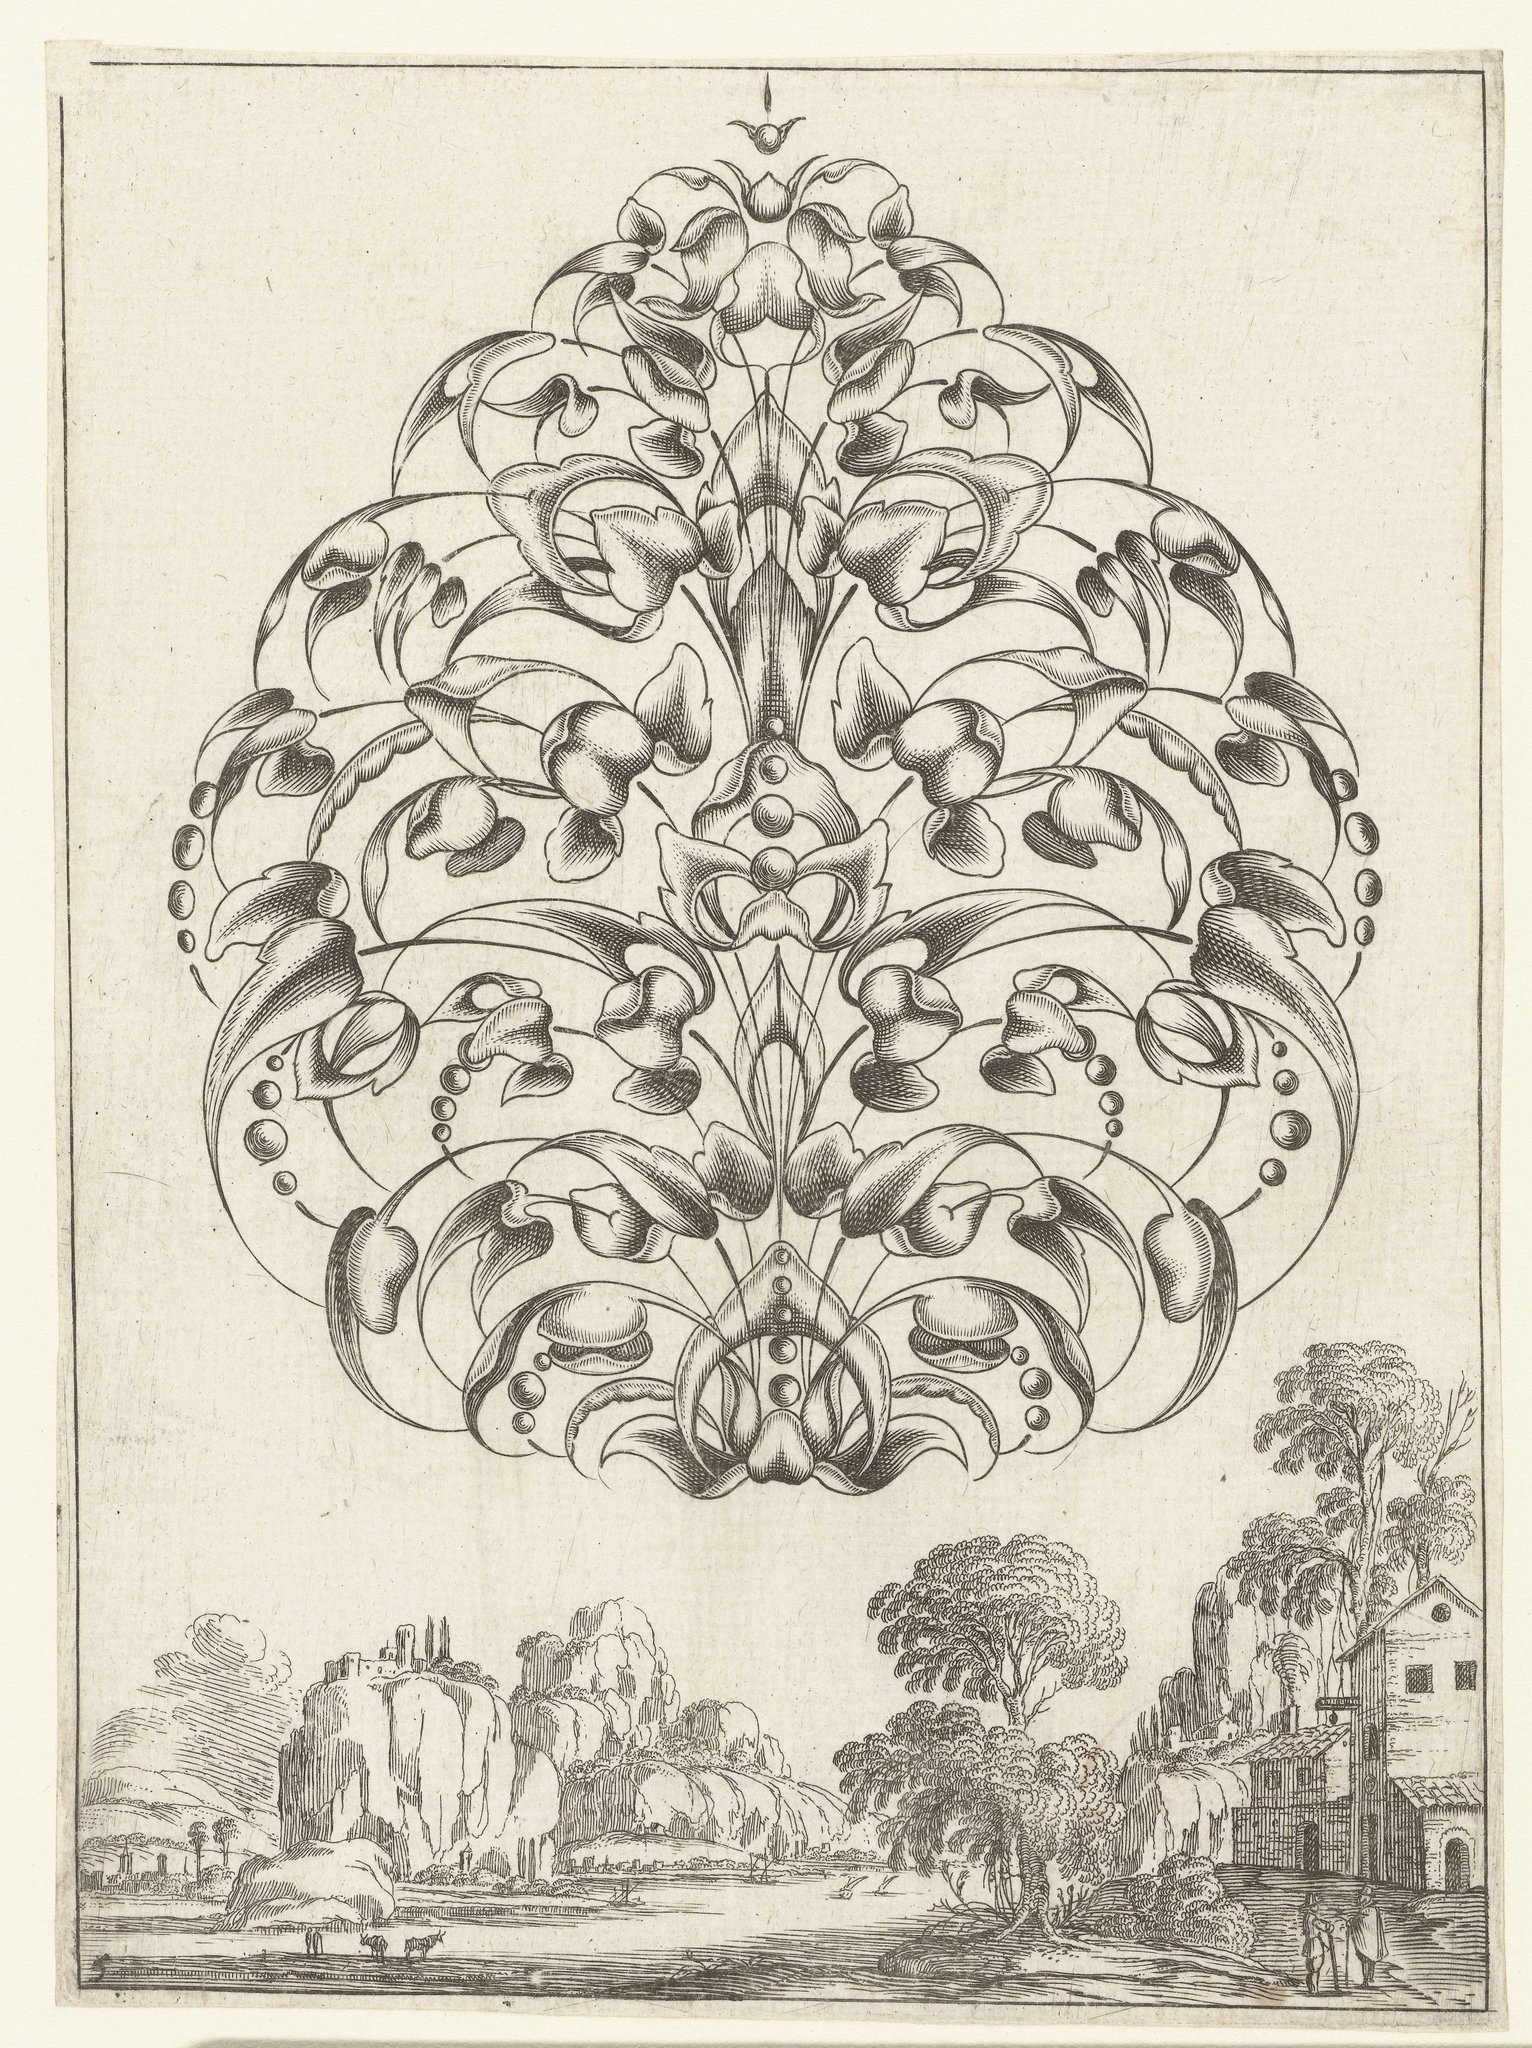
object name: print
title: Goudsmidsboeketten boven landschappen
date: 1626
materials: paper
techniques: engraving, etching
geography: paris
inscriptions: collector's mark: Lugt 240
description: Ontwerp voor een borstsieraad in peulvruchtenstijl, onderaan een rivierlandschap met rechts enkele huizen en twee figuurtjes. Uit serie van 6 bladen met goudsmidsboeketten in peulvruchtenstijl.